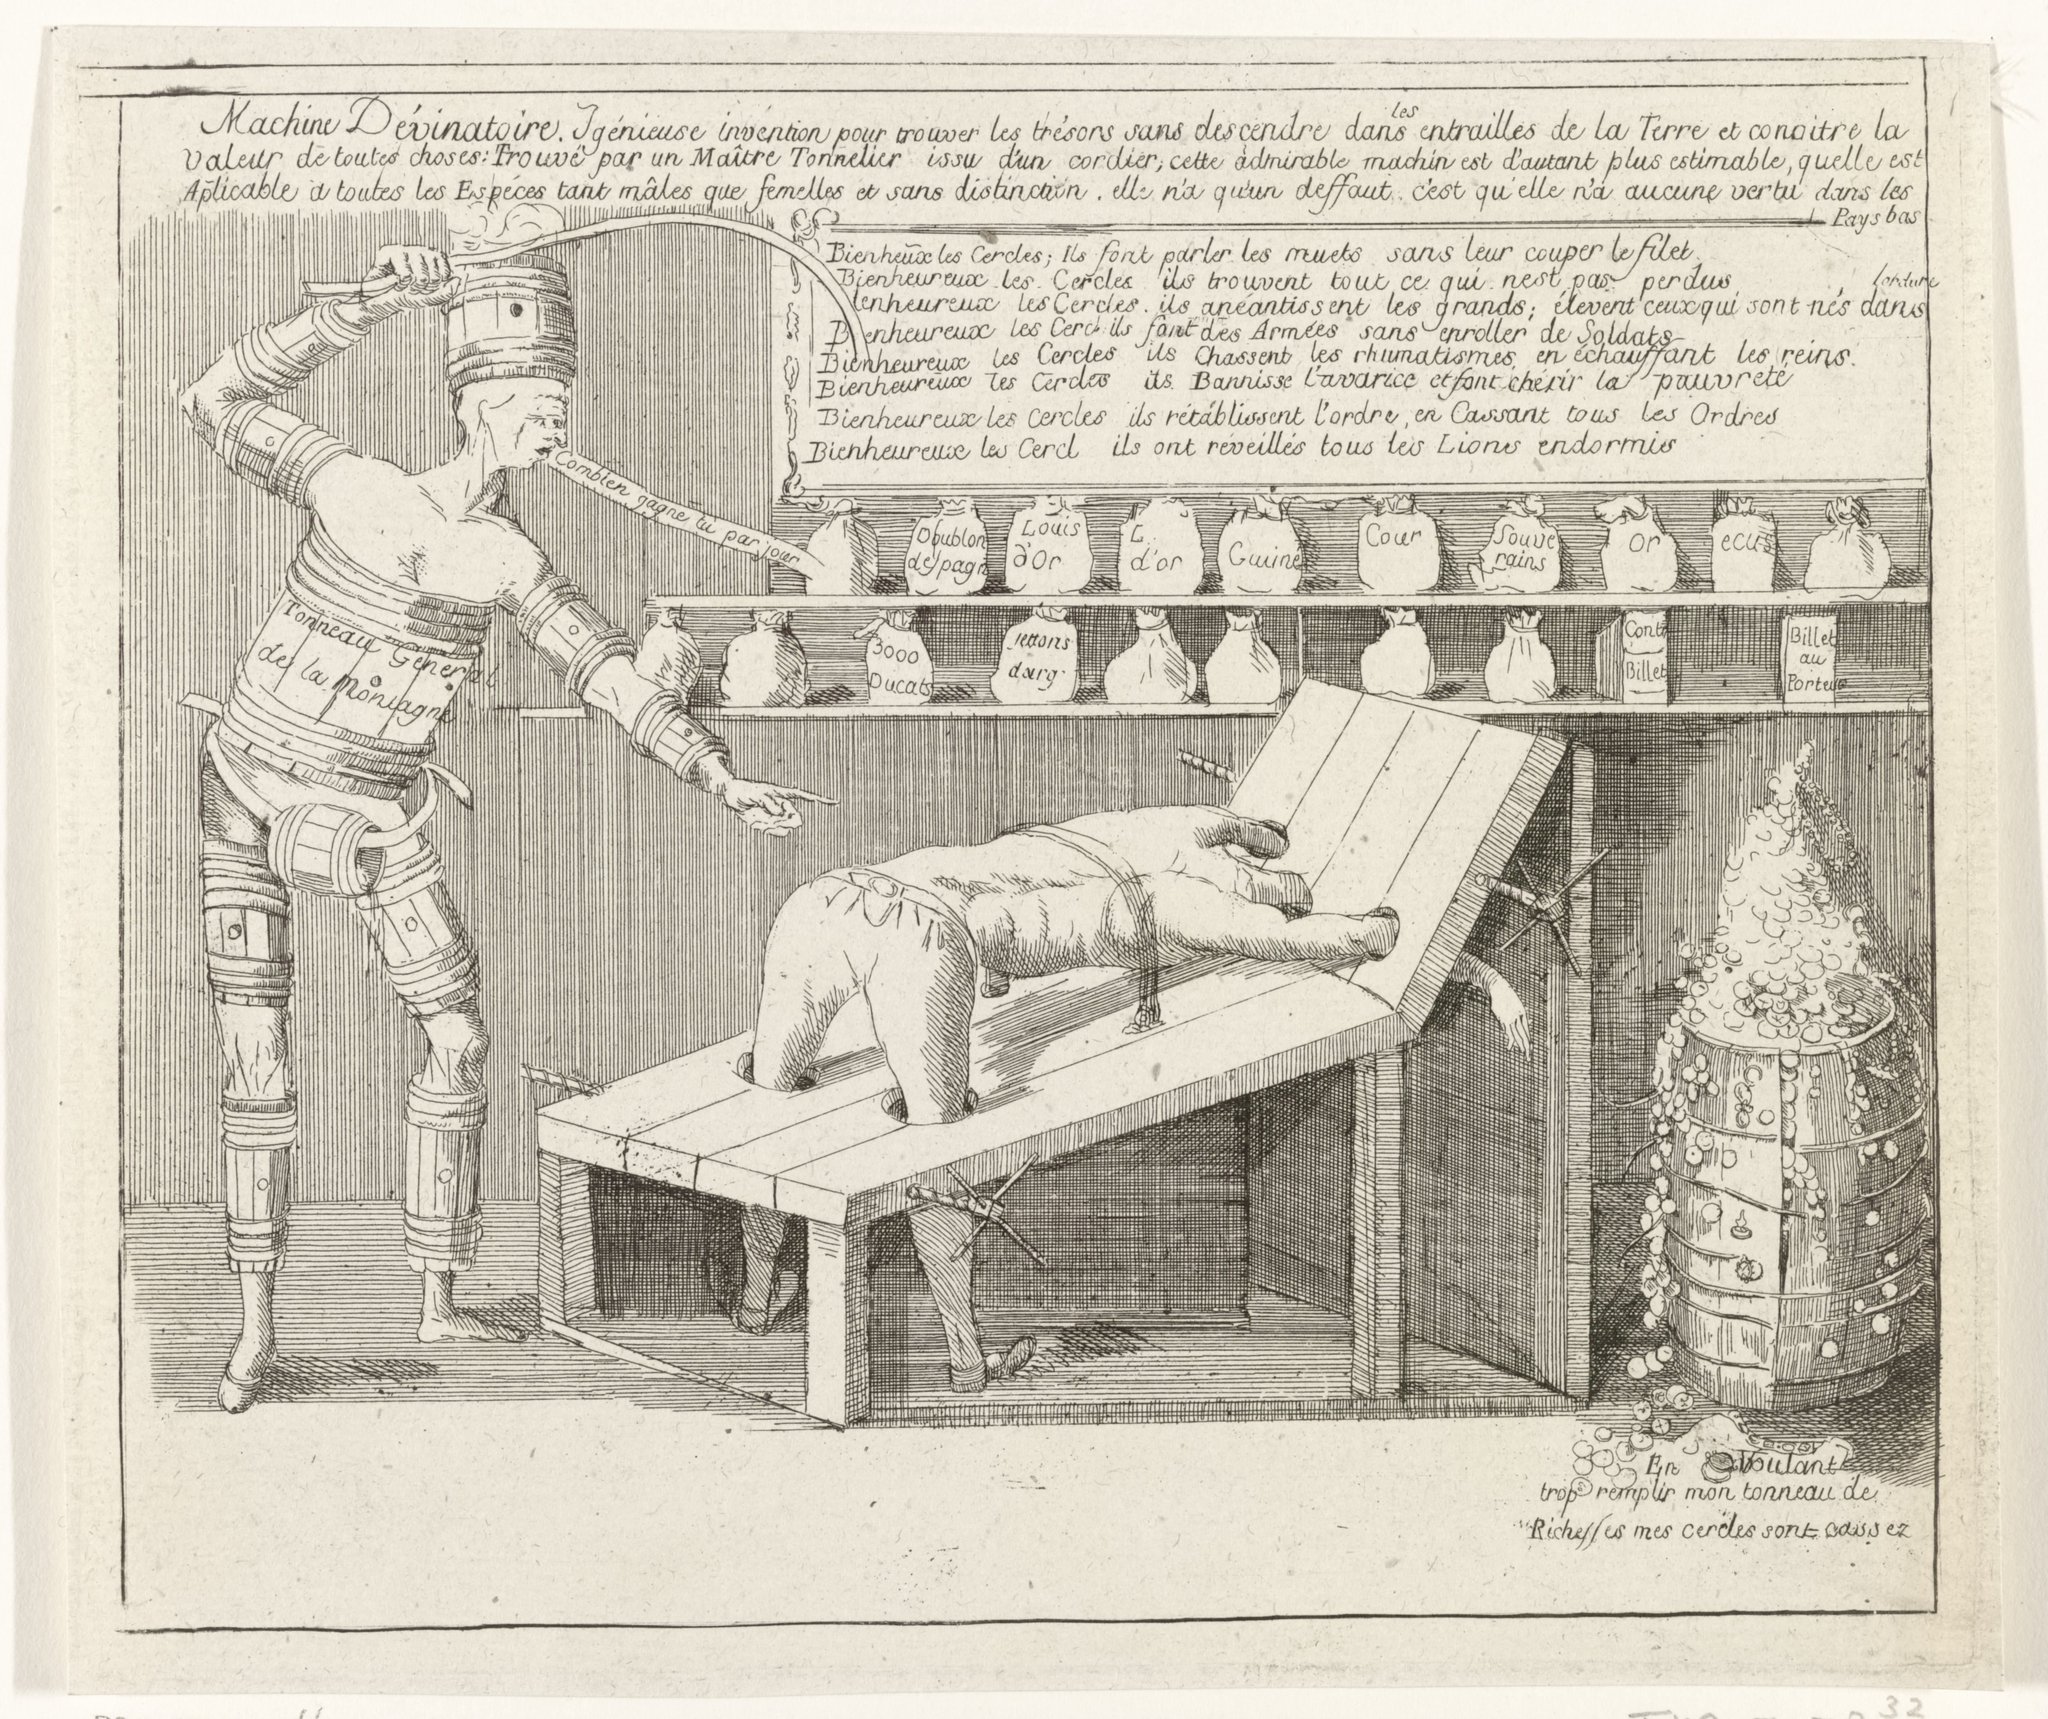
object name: cartoon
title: Machine Dévinatoire Igénieuse pour trouver les trésors (...)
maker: Anonymous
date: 1787-1790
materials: paper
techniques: engraving, etching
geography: southern netherlands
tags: torture, spanking, drubbing (of naughty children), brabant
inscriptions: collector's mark: Lugt 2228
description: Spotprent waarin een man in een schandblok met een zweep op zijn achterste wordt gegeseld. Links staat een figuur bestaande uit houten tonnen, rechts een vat met geldstukken, barstend uit de voegen. Onderdeel van een grote groep van prenten betrekking hebbend op de gebeurtenissen van de Brabantse Omwenteling en de periode 1787-1790.